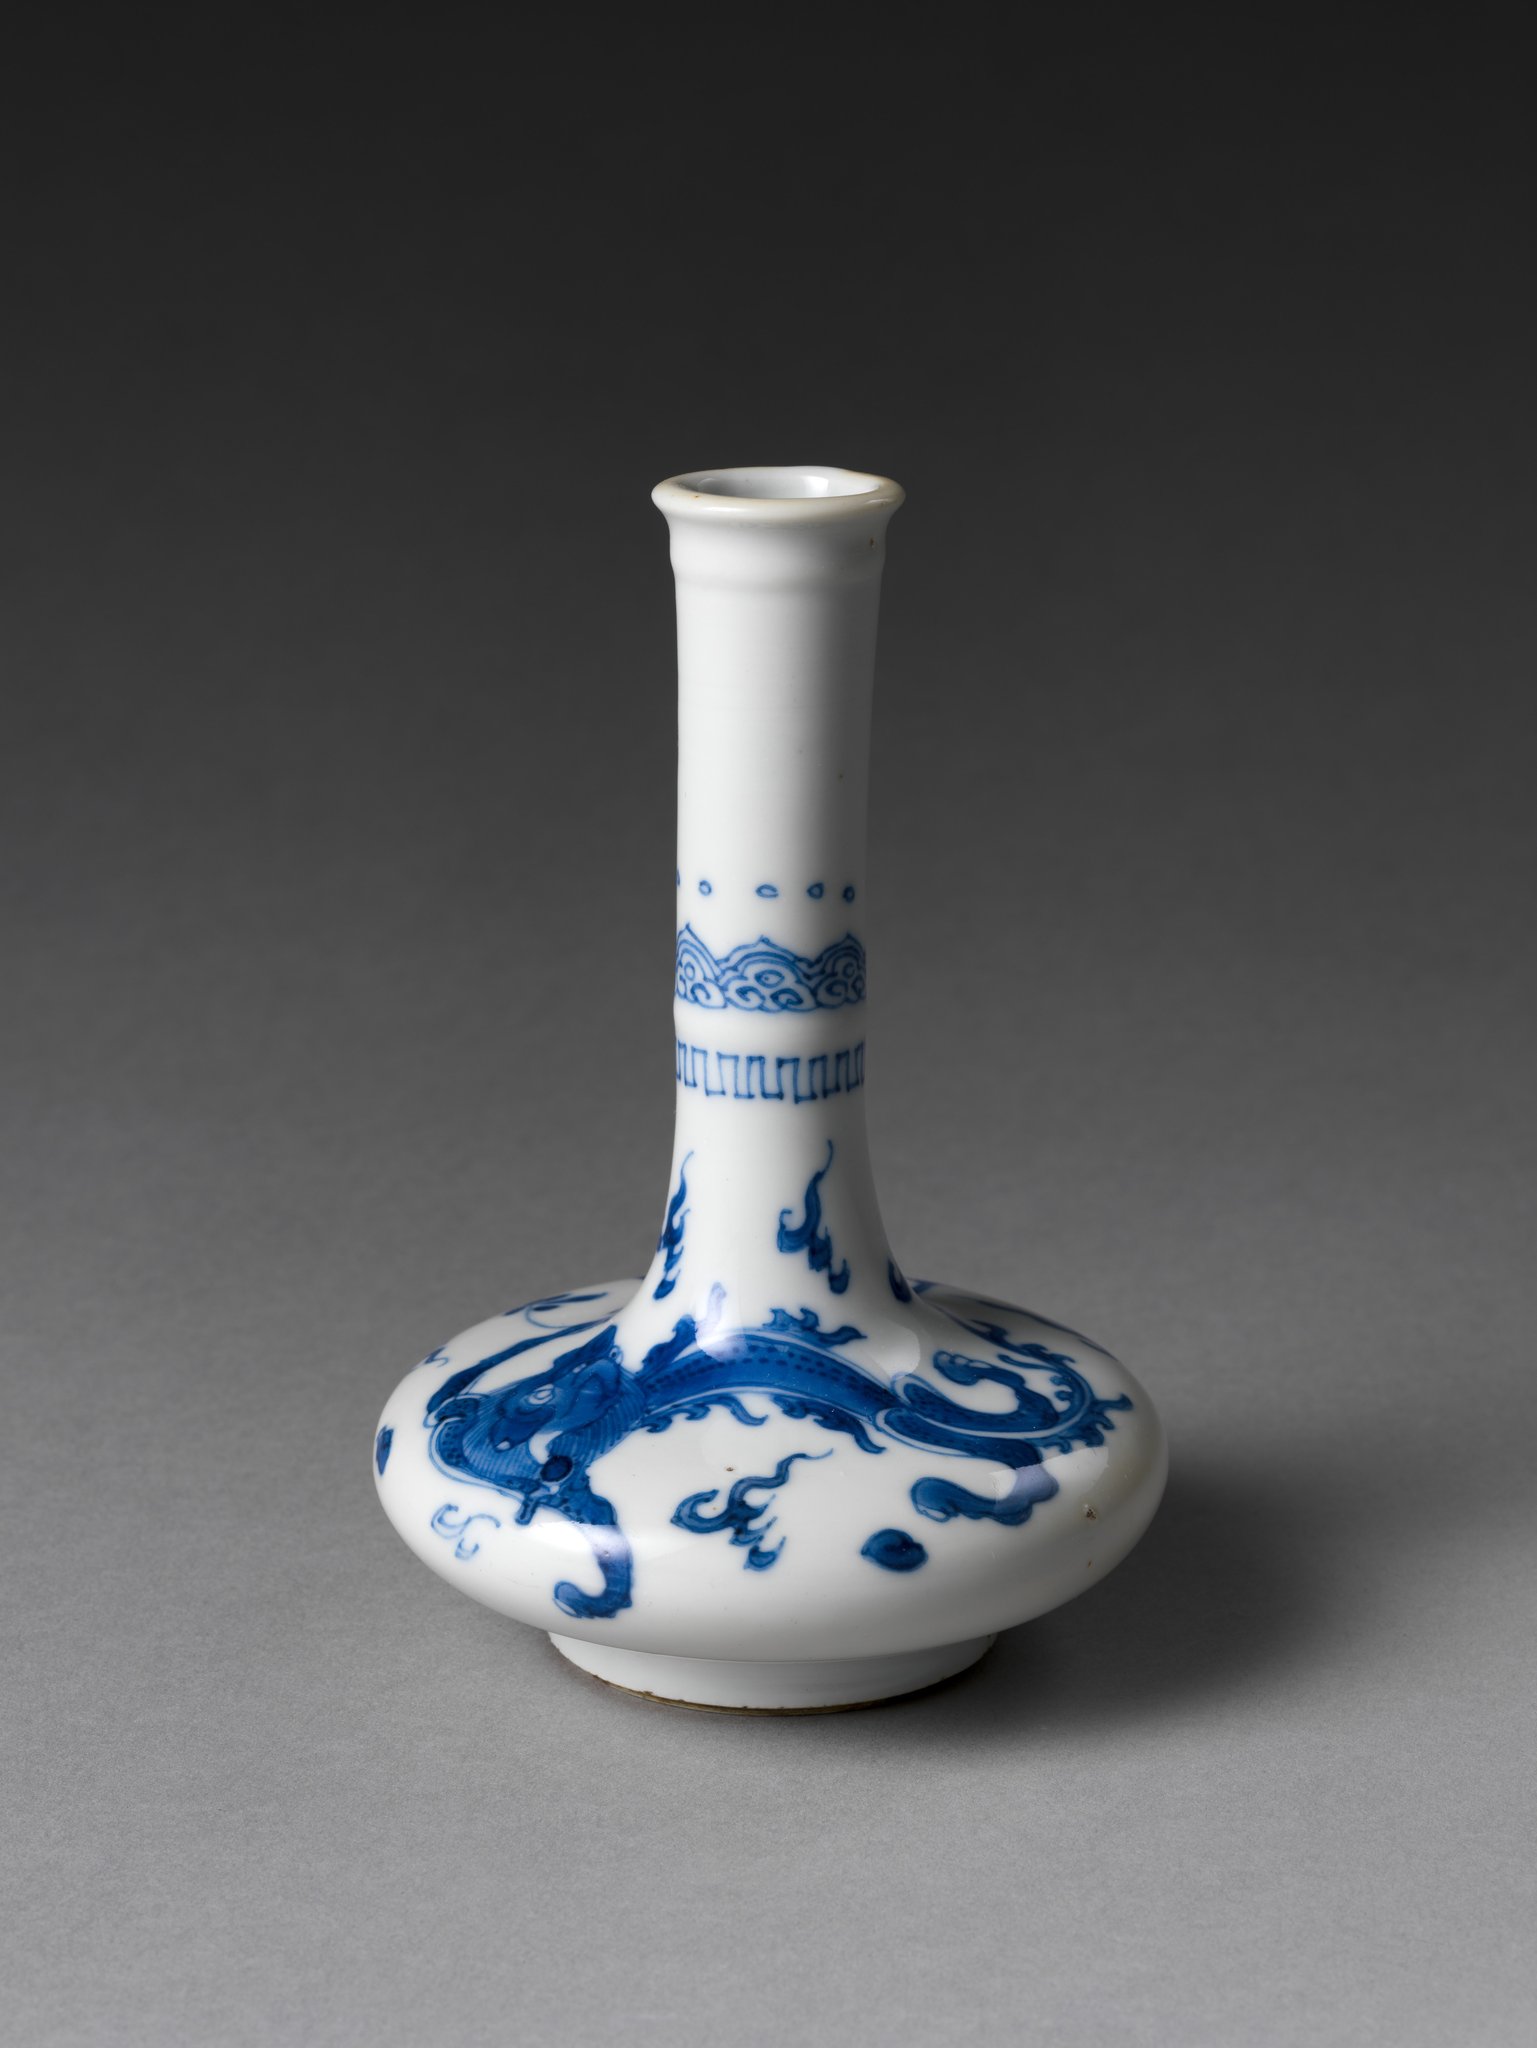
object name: bottle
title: Bottle with Dragon Chasing Pearl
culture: chinese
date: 1667-1733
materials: cobalt, glaze, porcelain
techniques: painting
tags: dragons